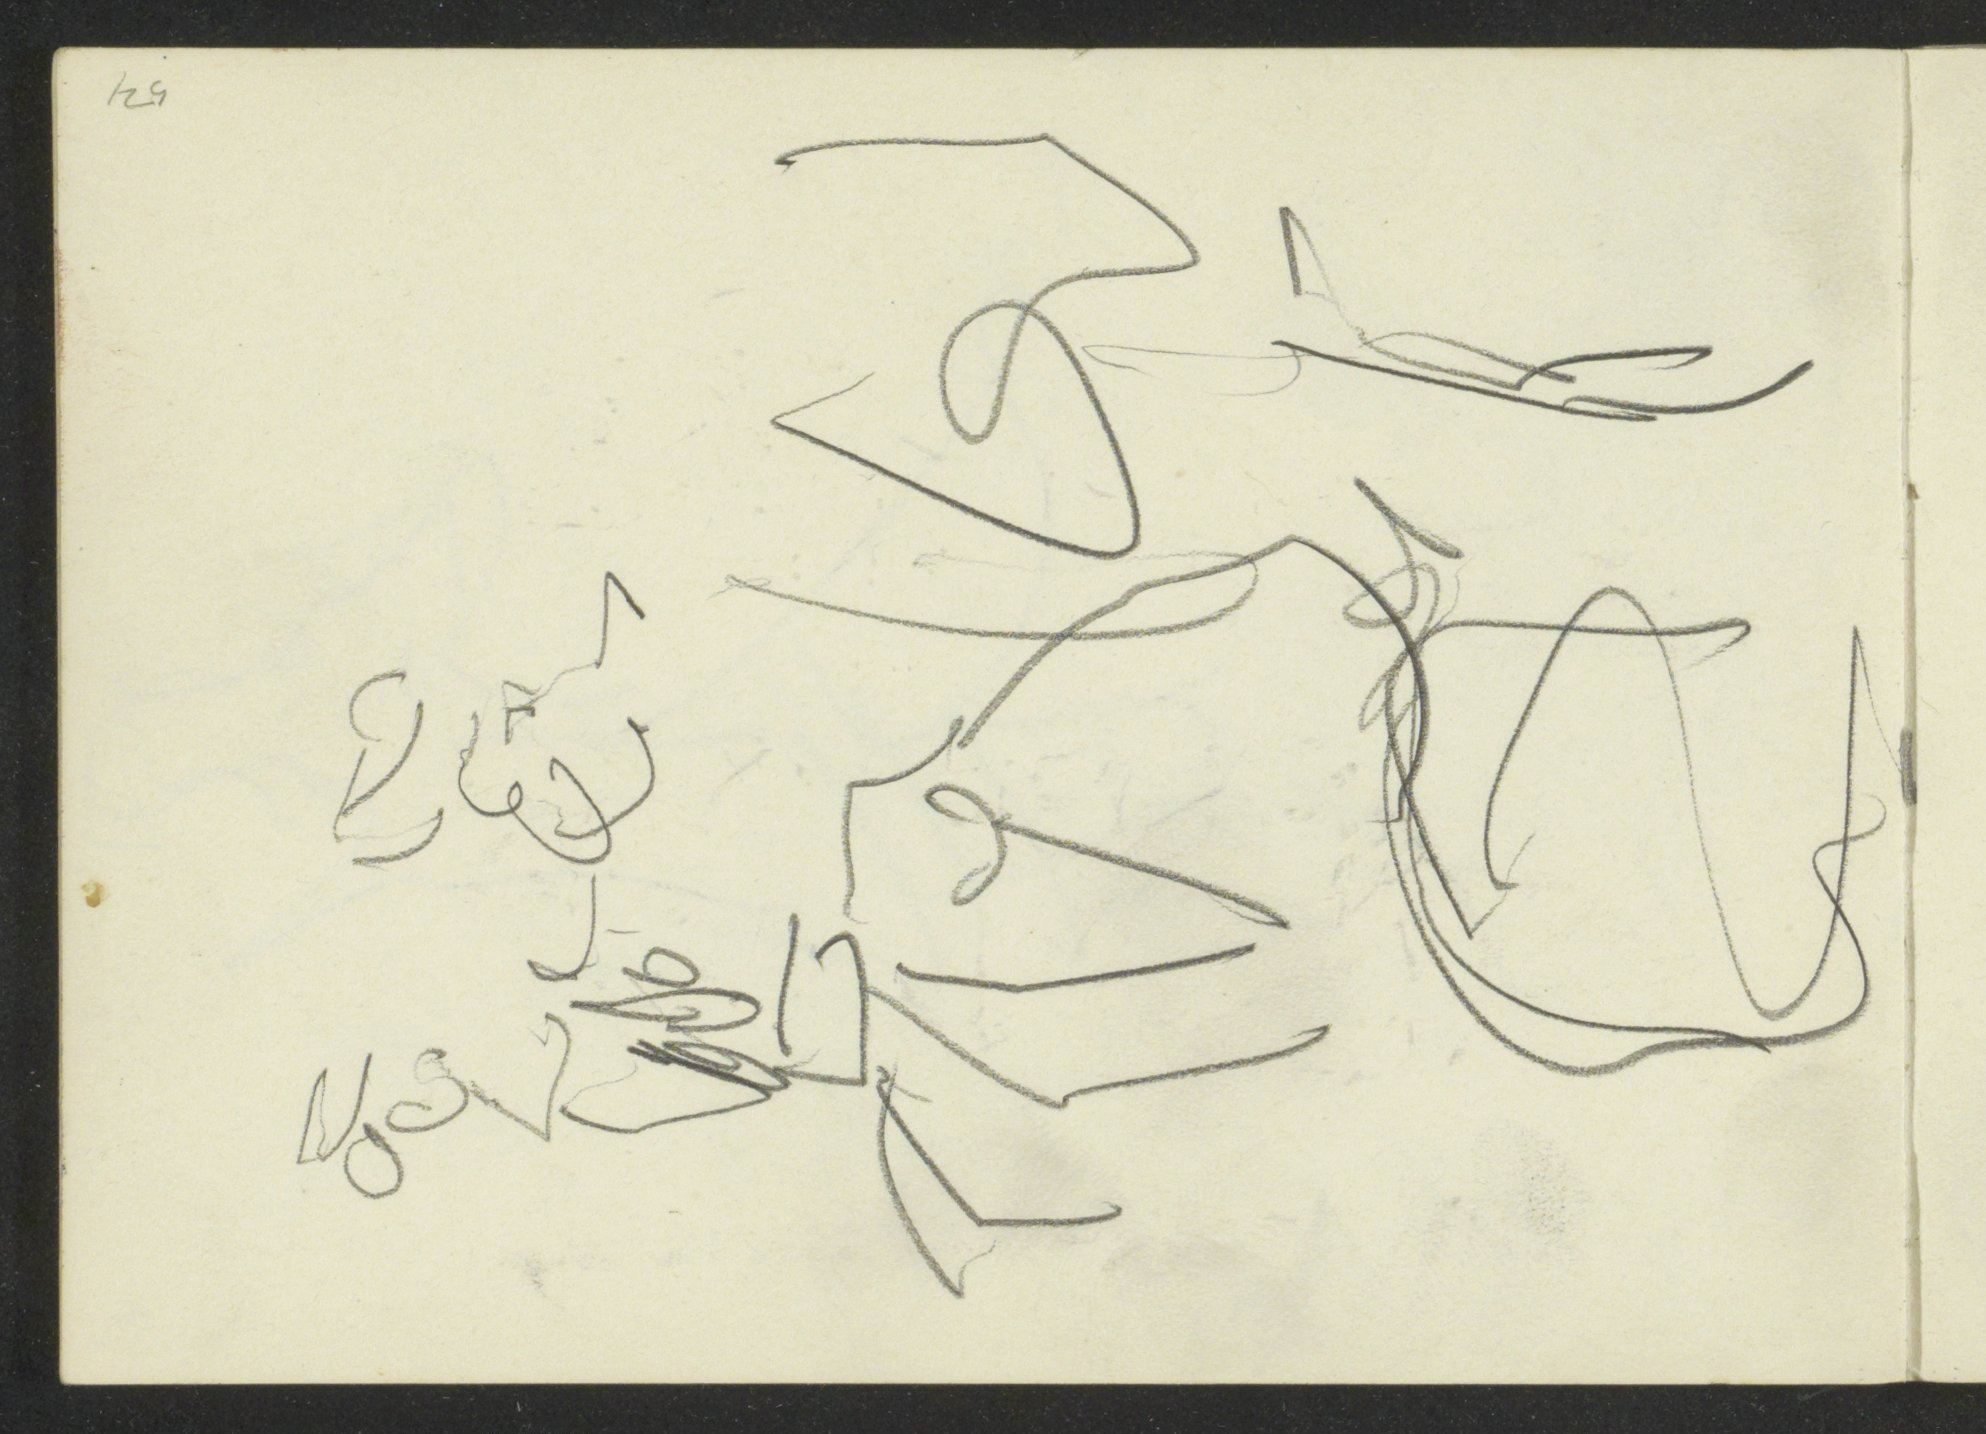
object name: sketchbook leaf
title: Figuurstudies, mogelijk van vrouwen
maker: isaac israels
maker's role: draughtsman, painter, print maker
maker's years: 1865-1934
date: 1875-1934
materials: paper, pencil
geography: the hague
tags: adult woman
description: Blad 5 verso uit schetsboek LVII met 29 bladen.